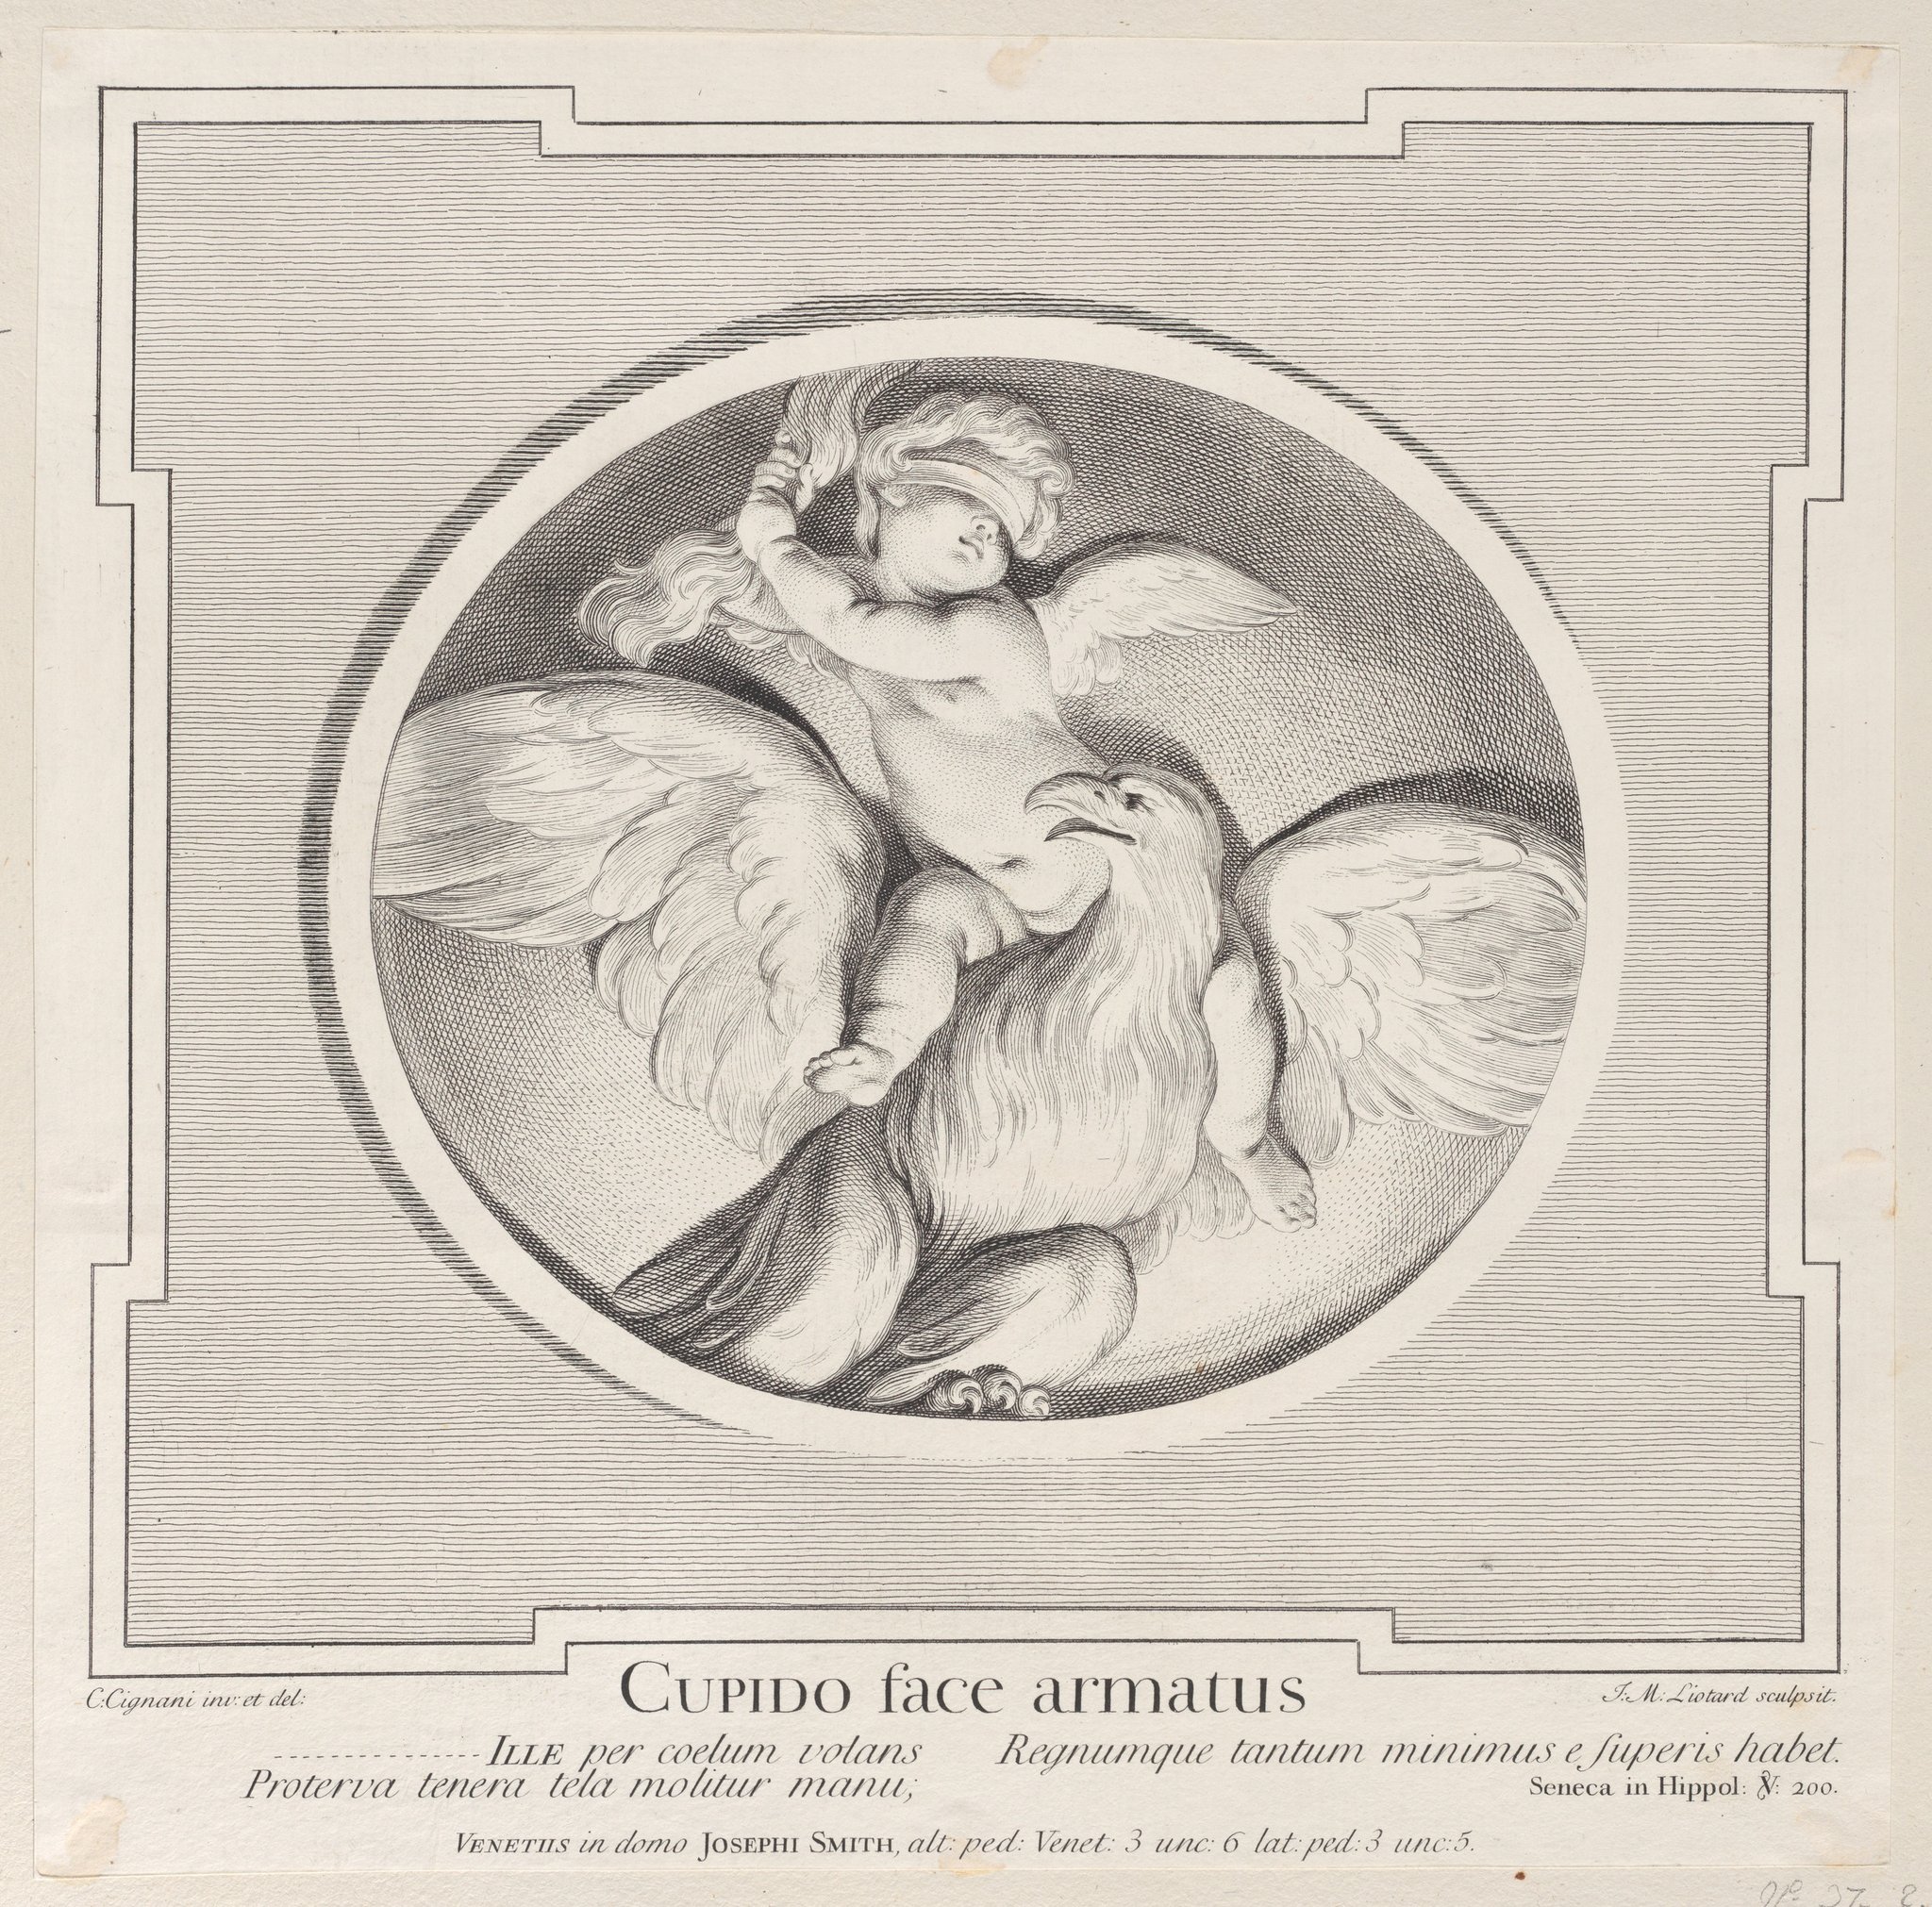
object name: print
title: Cupid Astride an Eagle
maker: jean michel liotard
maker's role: artist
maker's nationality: swiss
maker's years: 1702-1796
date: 1715-1796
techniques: engraving, etching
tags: eagles,cupid